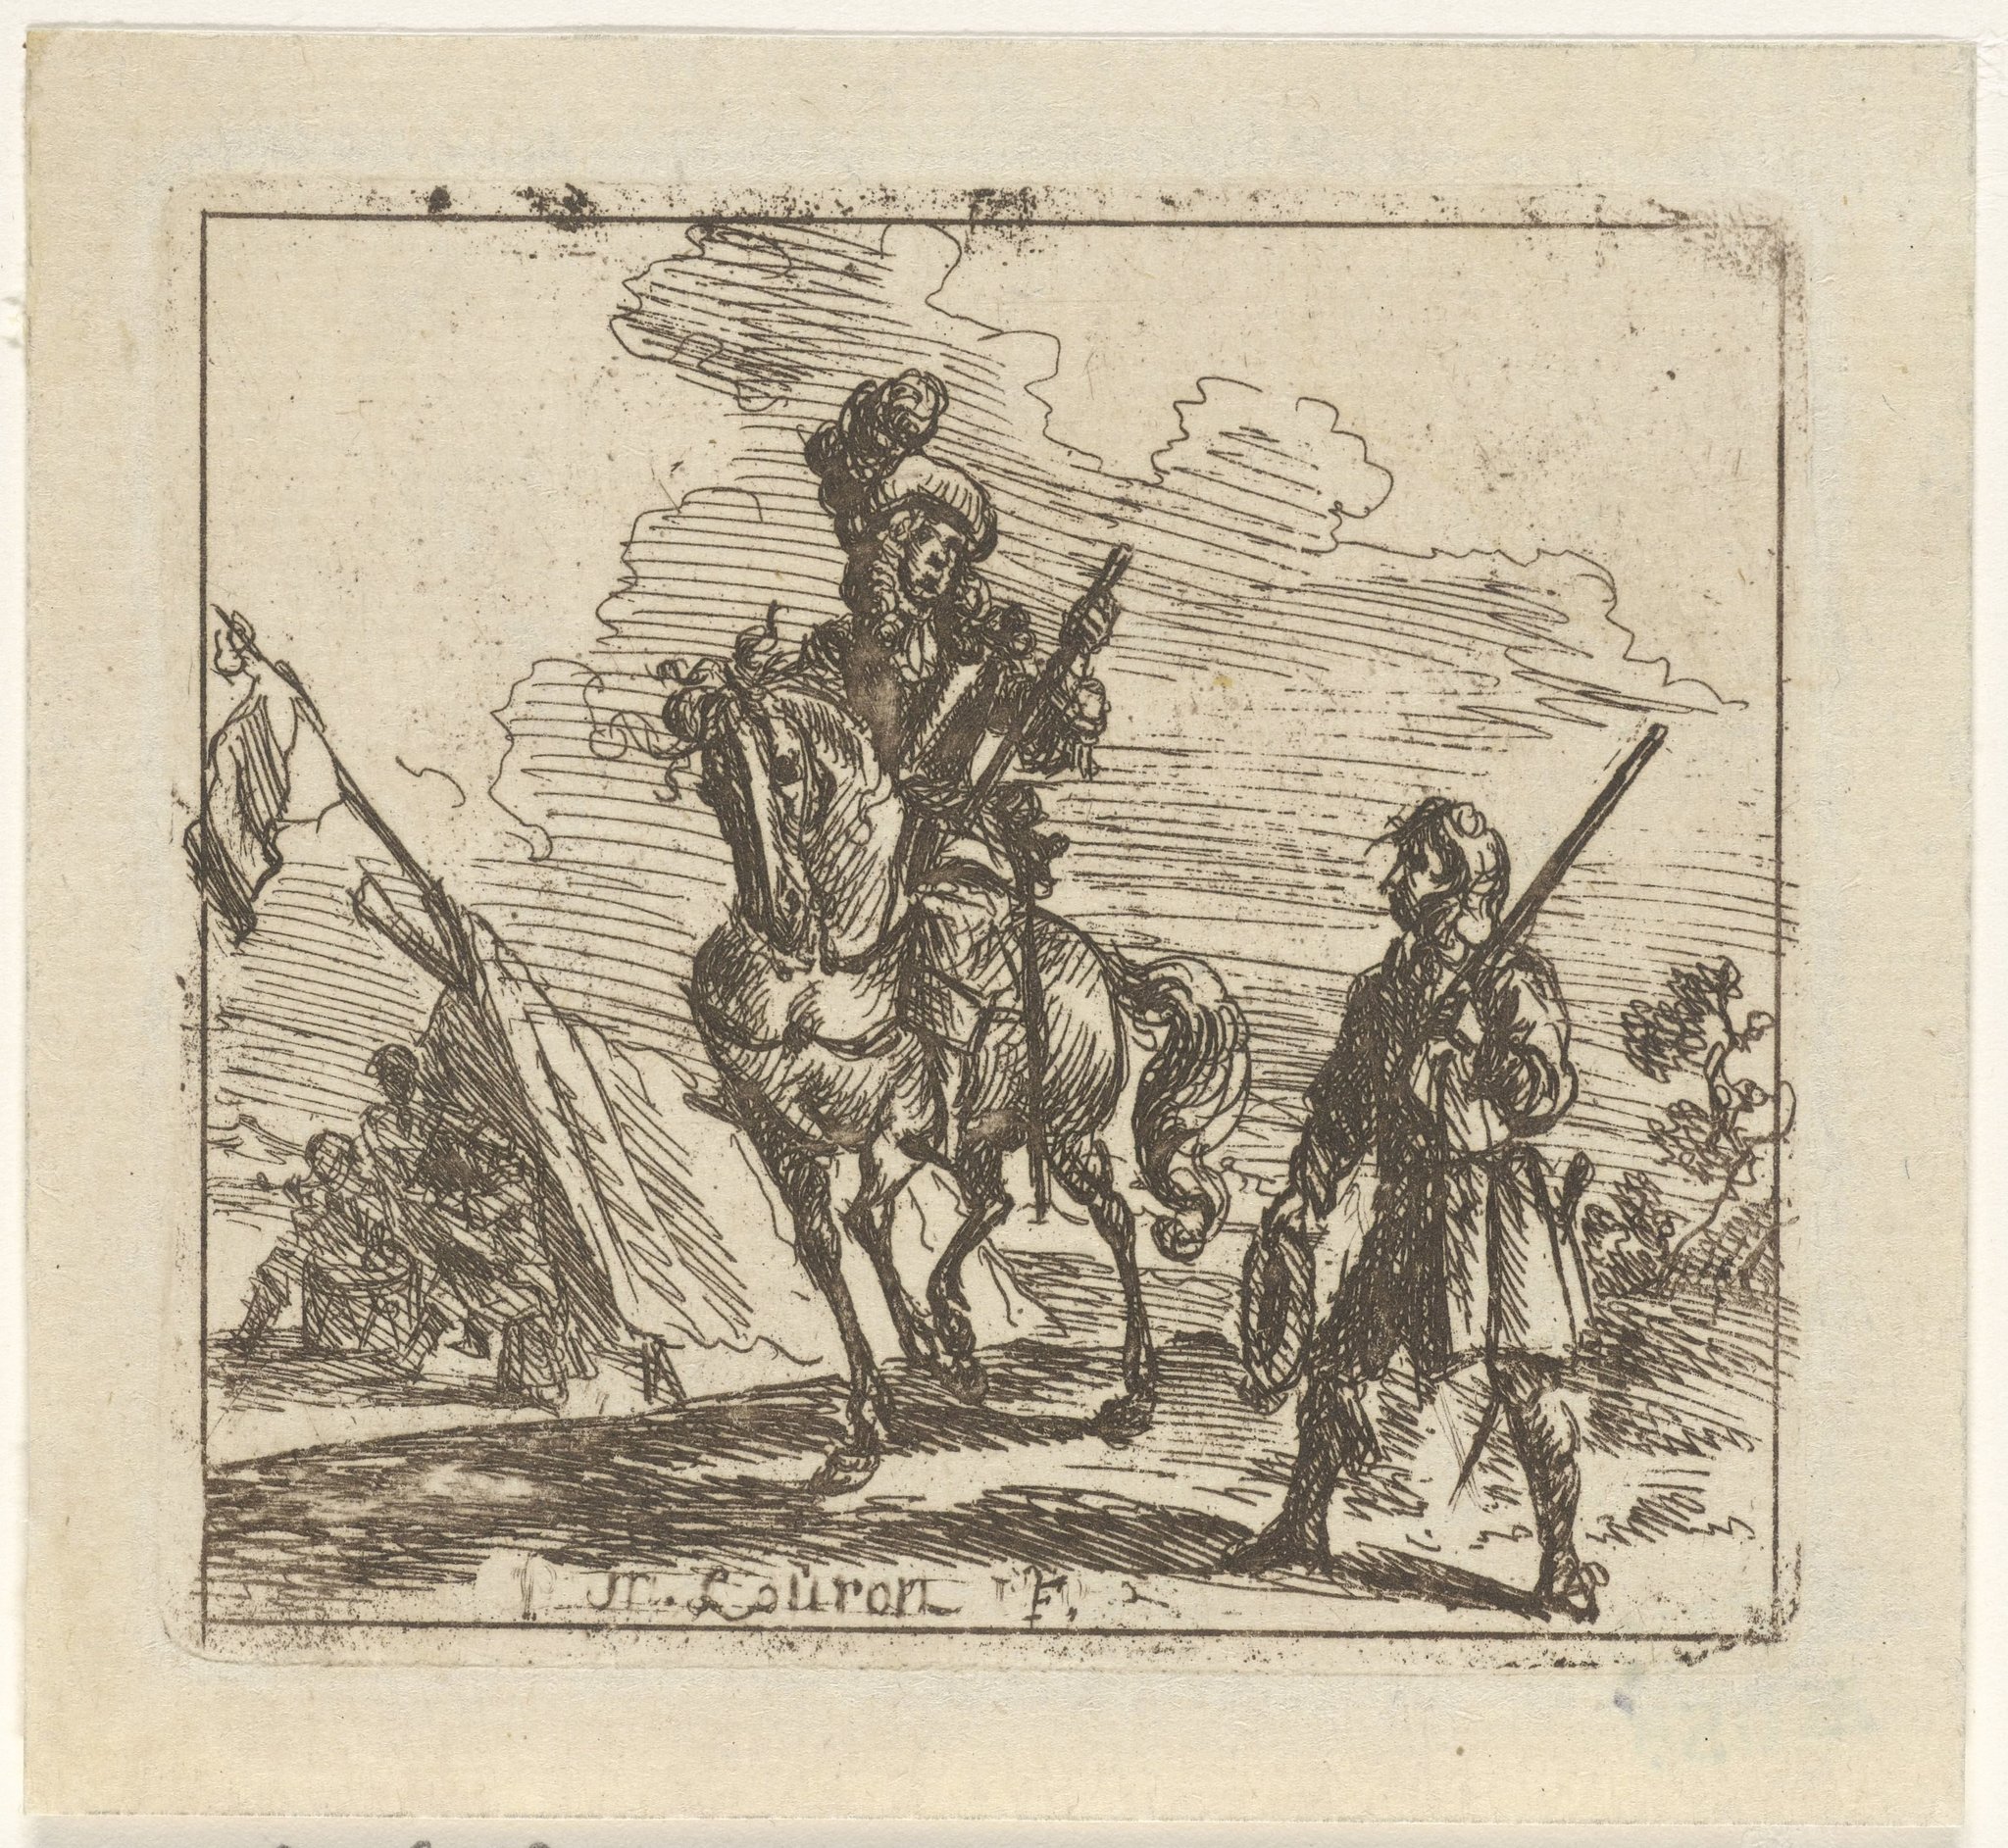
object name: print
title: Generaal te paard deelt bevelen uit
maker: marcellus laroon (i)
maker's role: painter, print maker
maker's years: 1653-1702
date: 1663-1702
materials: paper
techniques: etching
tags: army 'en route', riding a horse, ass, or mule; rider, horseman, commander-in-chief, general, marshal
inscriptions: collector's mark: Lugt 2165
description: Een generaal te paard deelt bevelen uit aan een musketier. Links op de achtergrond staat een legertent.